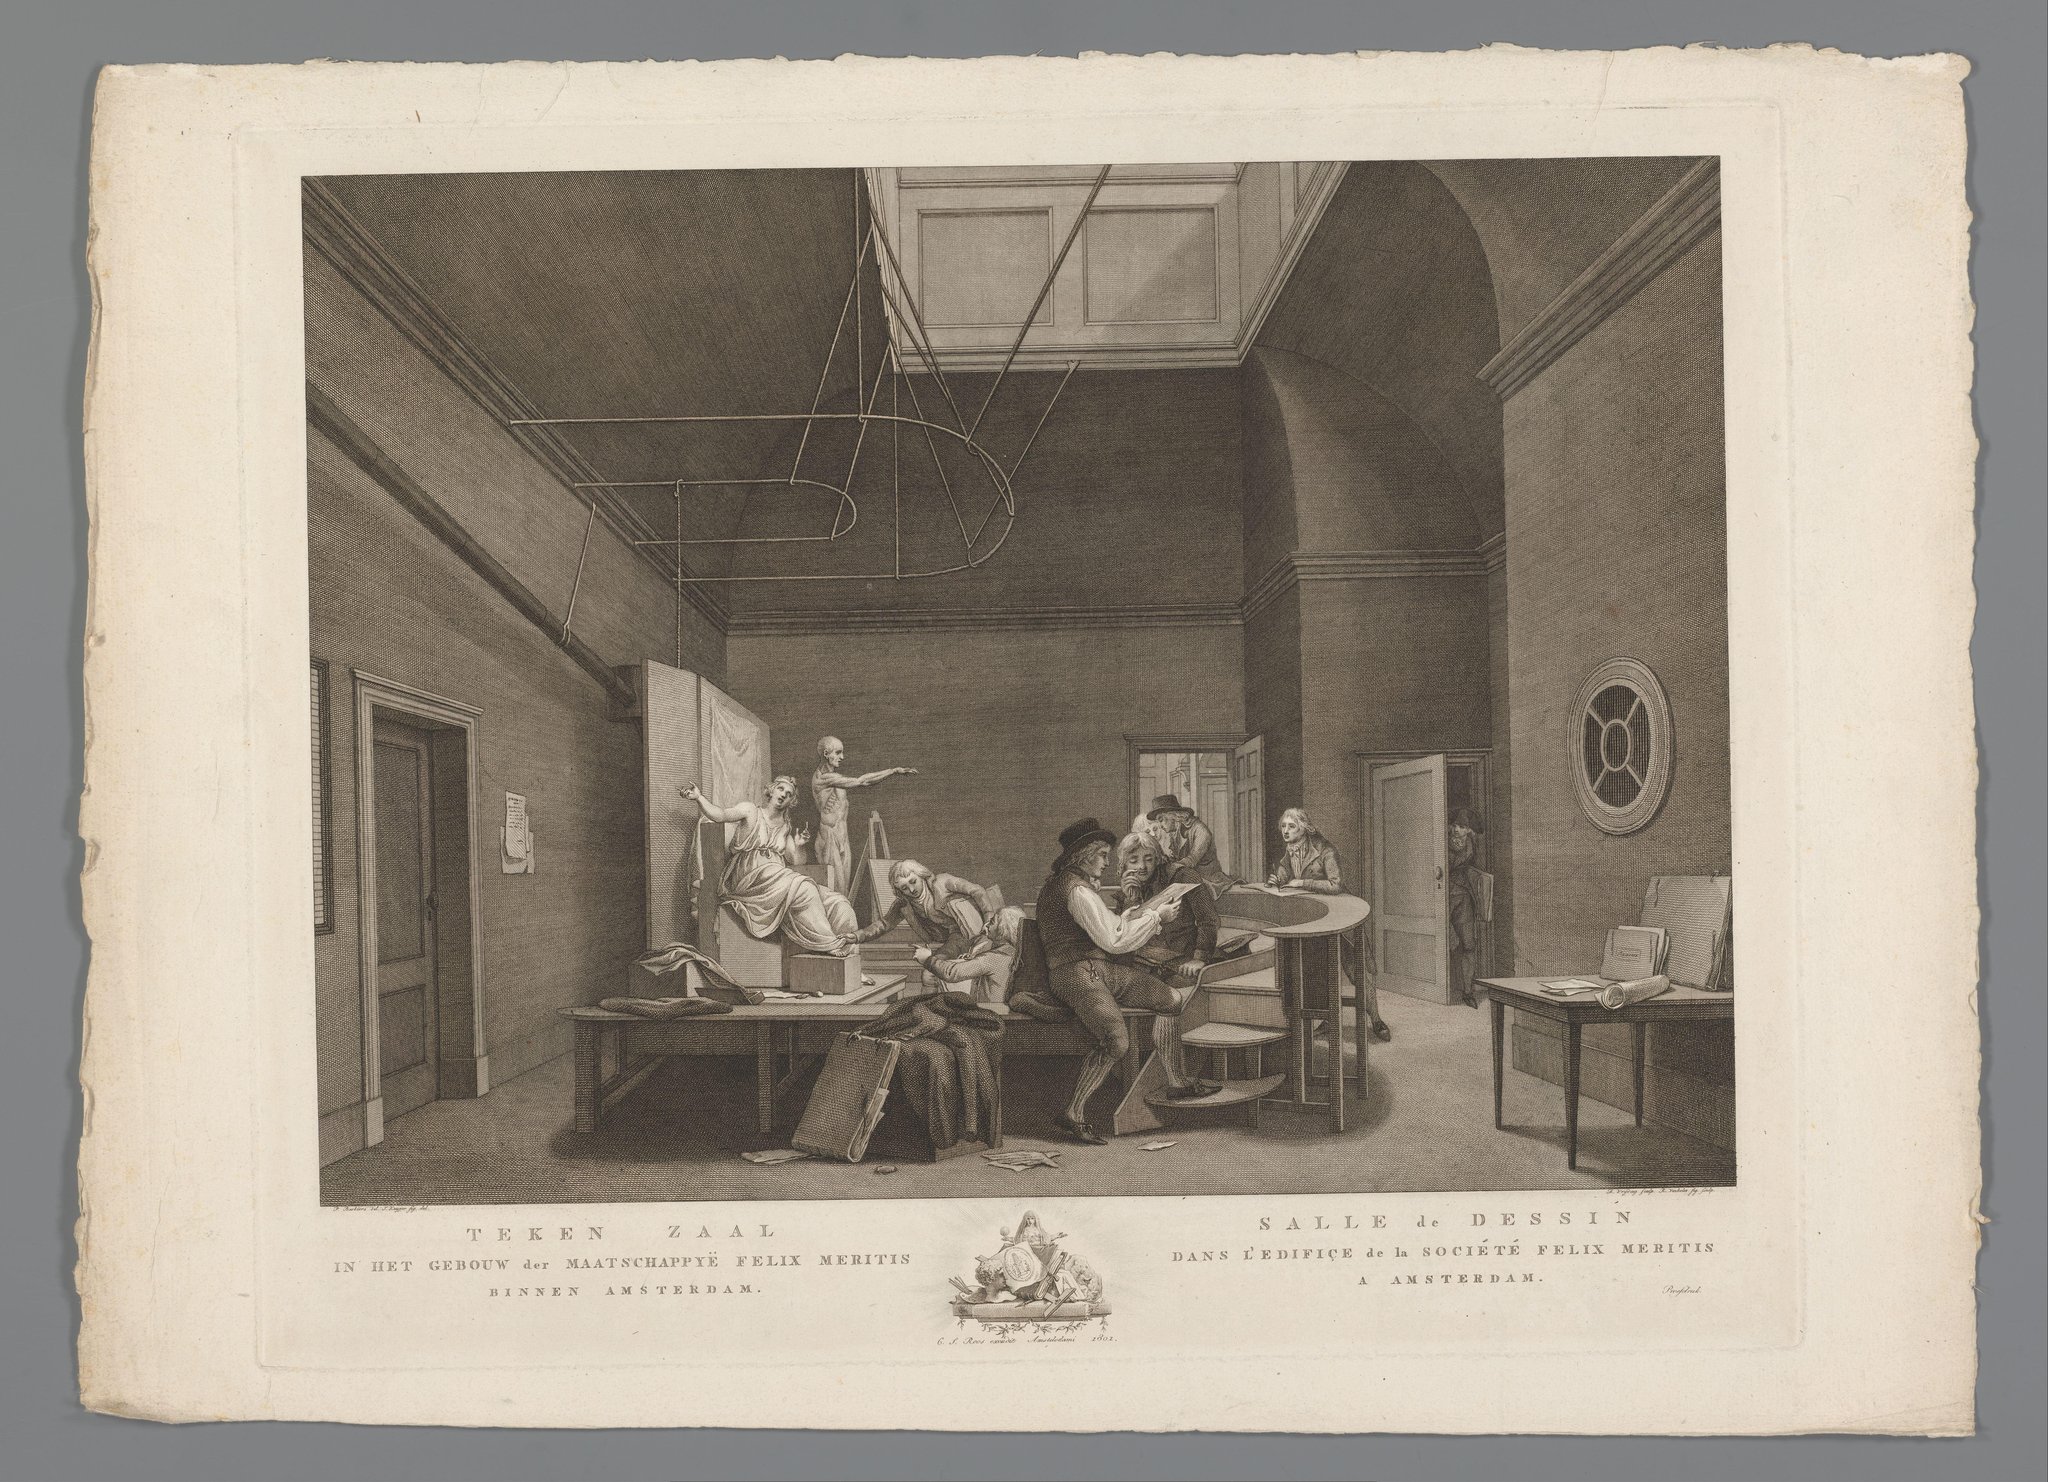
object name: print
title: Vier zalen in Felix Meritis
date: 1801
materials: paper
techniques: engraving, etching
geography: northern netherlands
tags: learned society, academy of sciences, drawing-lesson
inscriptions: collector's mark: Lugt 2228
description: Tekenles in de Tekenzaal in het gebouw van de maatschappij Felix Meritis te Amsterdam, ingewijd in 1789. Kunstenaars tekenen naar gipsmodel.